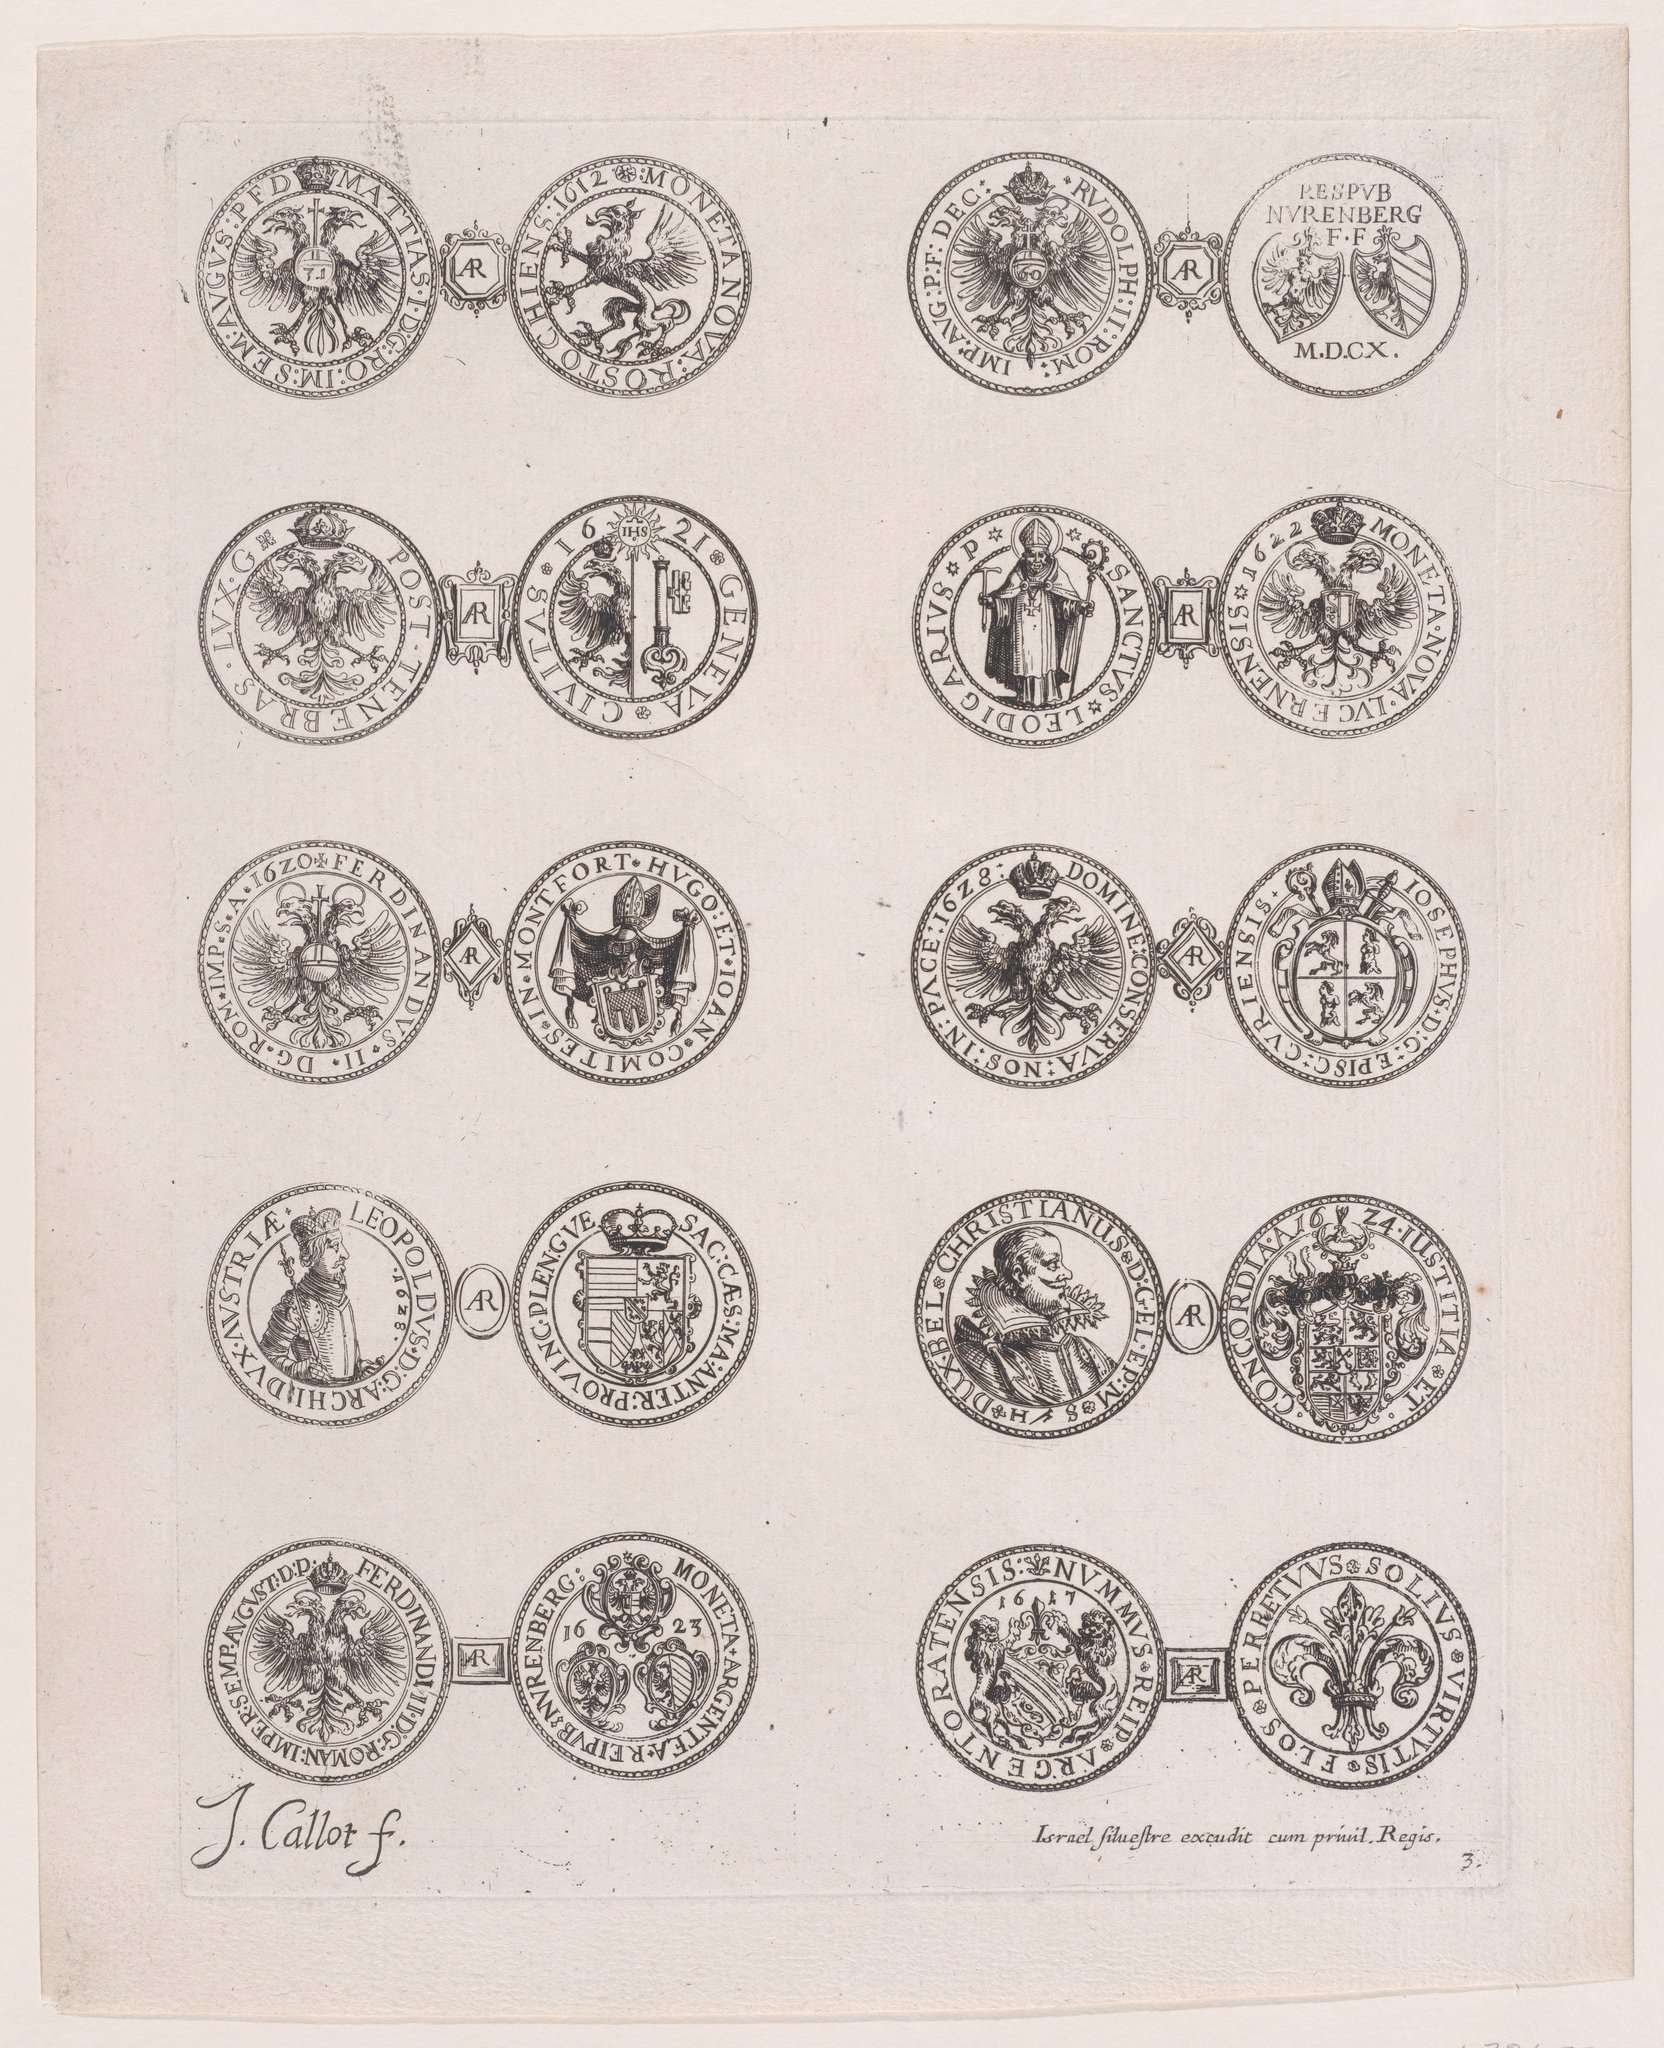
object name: print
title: Plate 3, Featuring 10 Coins Issued by European Princes in the 16th and 17th centuries, from "Les Monnaies" (The Currencies)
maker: jacques callot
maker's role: artist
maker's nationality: french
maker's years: 1592-1635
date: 1630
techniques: etching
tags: coins